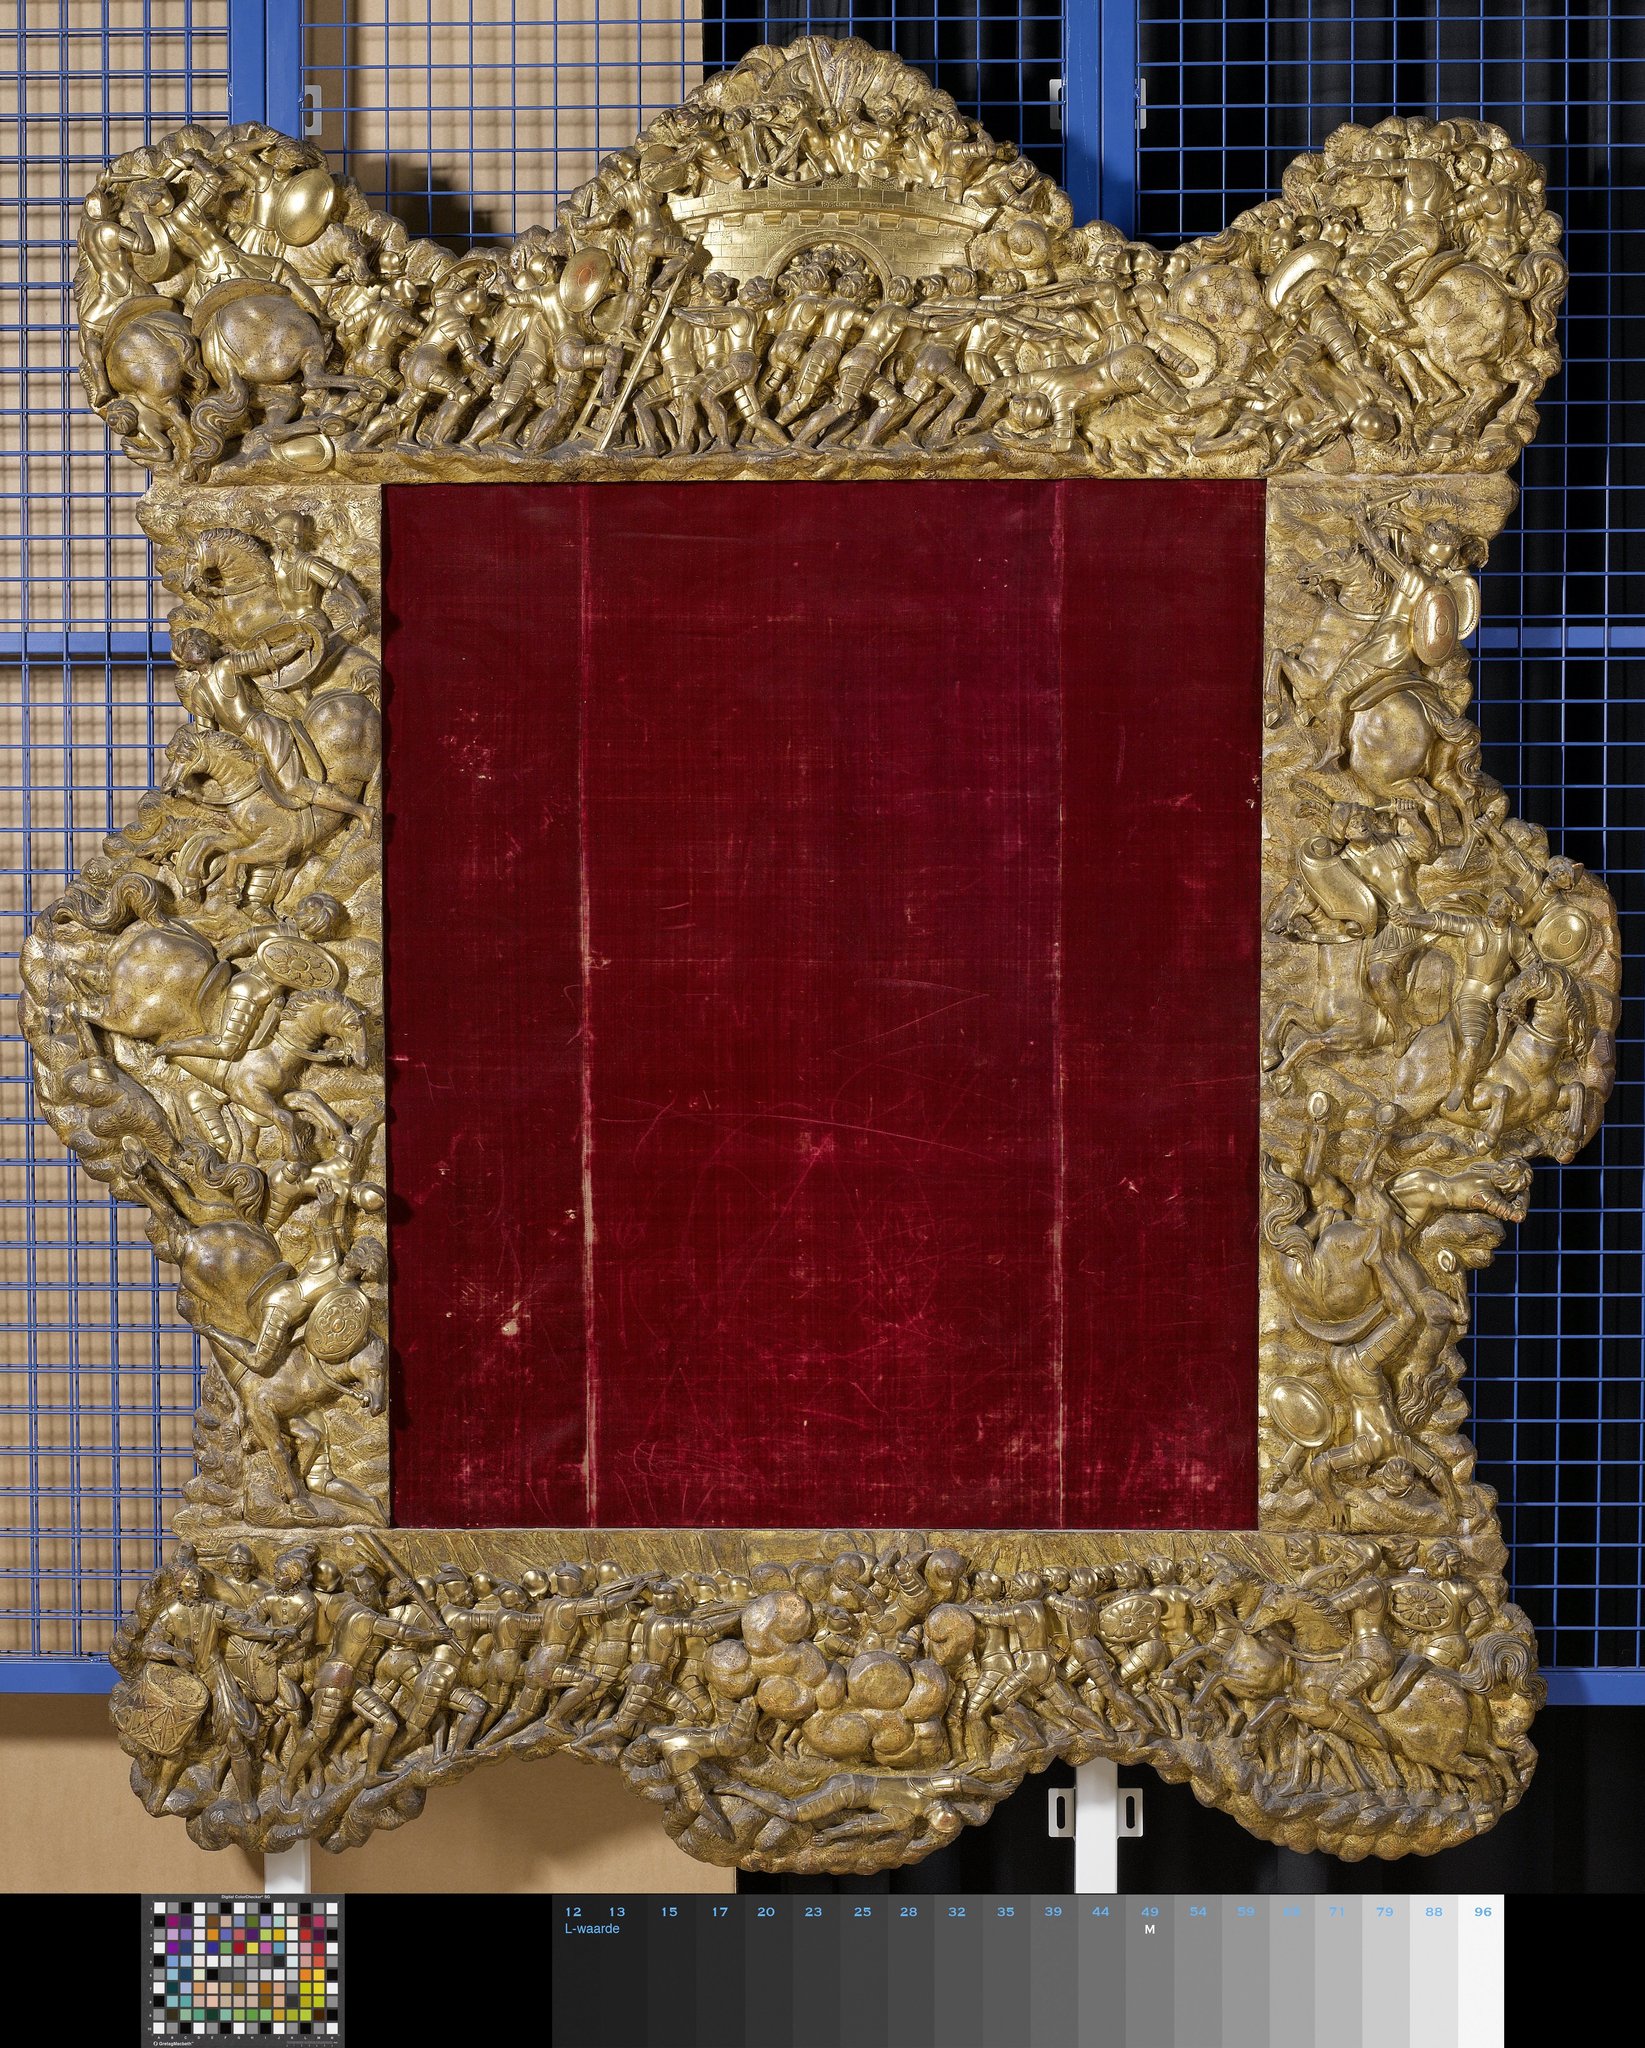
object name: sculpture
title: Vergulde lijst met gesneden ornamenten: gevechten tussen Turken en Europeanen.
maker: Anonymous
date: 1550-1574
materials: gold leaf, velvet, wood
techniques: gilding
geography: venice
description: Lijst met gesneden versiering: gevechten tussen Turken en Europeanen.